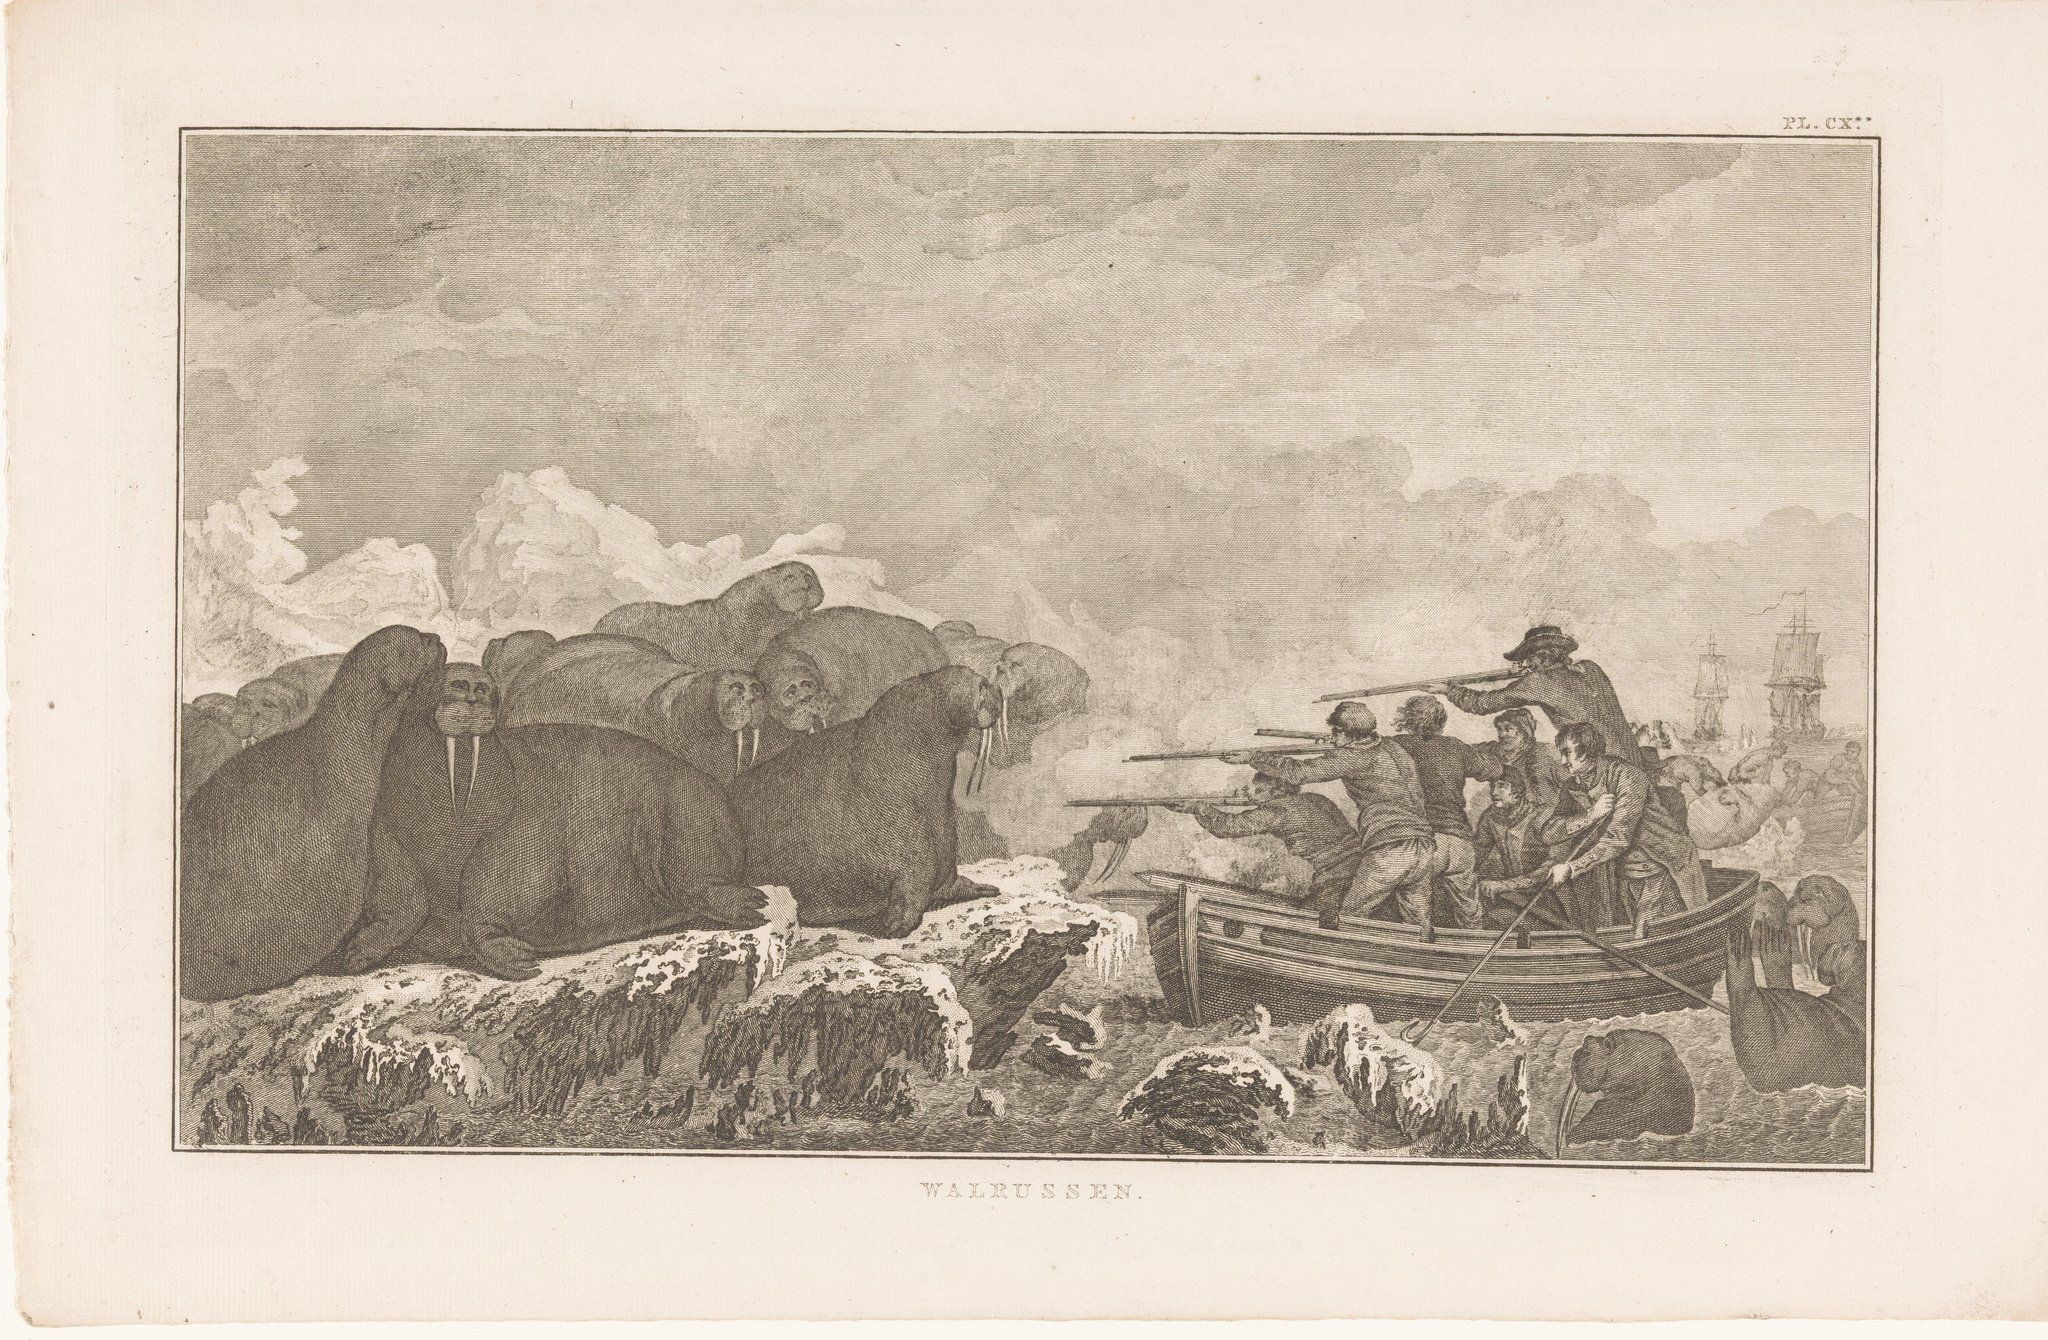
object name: print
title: Walrusjacht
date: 1795-1809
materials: paper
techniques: etching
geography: leiden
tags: swimming mammals: walrus, hunt ~ marine mammals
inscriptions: collector's mark: Lugt 2228, collector's mark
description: Prent ook gebruikt in: Cook, James. Reize rondom de waereld door James Cook. Leiden: Jan Honkoop en Abraham (II) Honkoop; Amsterdam: Allart, Johannes, 1795-1809, dl. 11, boek 4, achter p. 280.